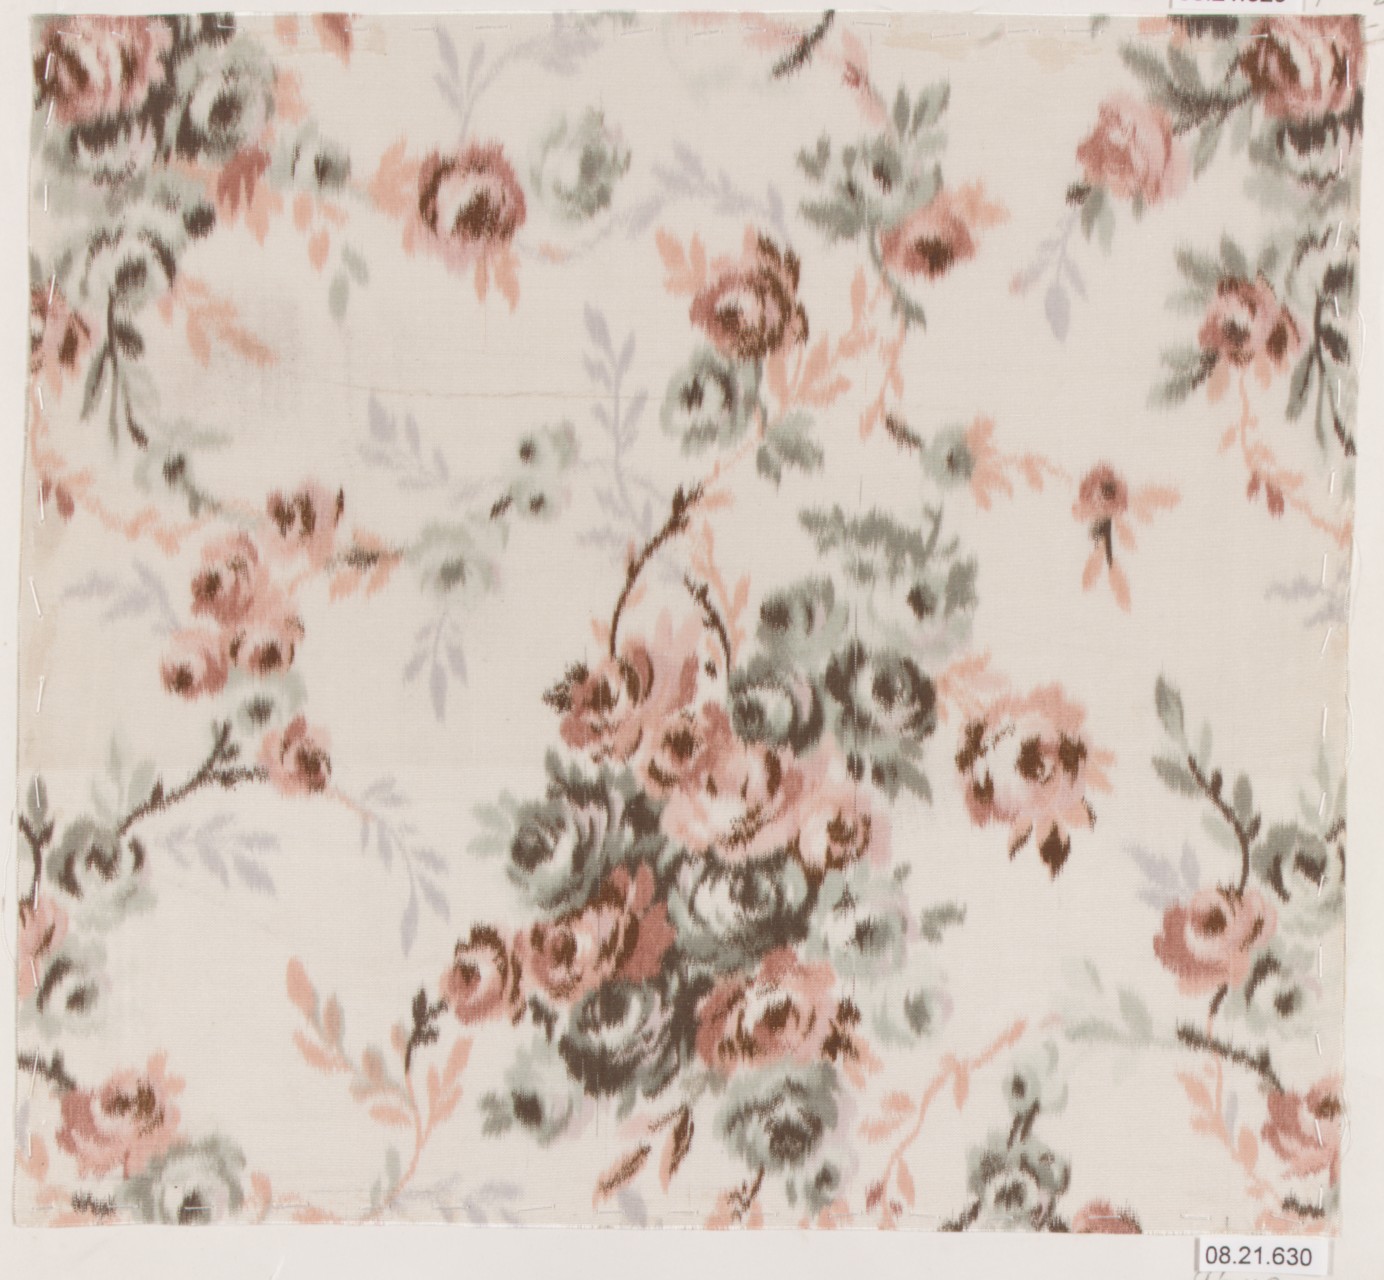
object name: textile sample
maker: Anonymous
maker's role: designer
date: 1900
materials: silk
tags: flowers